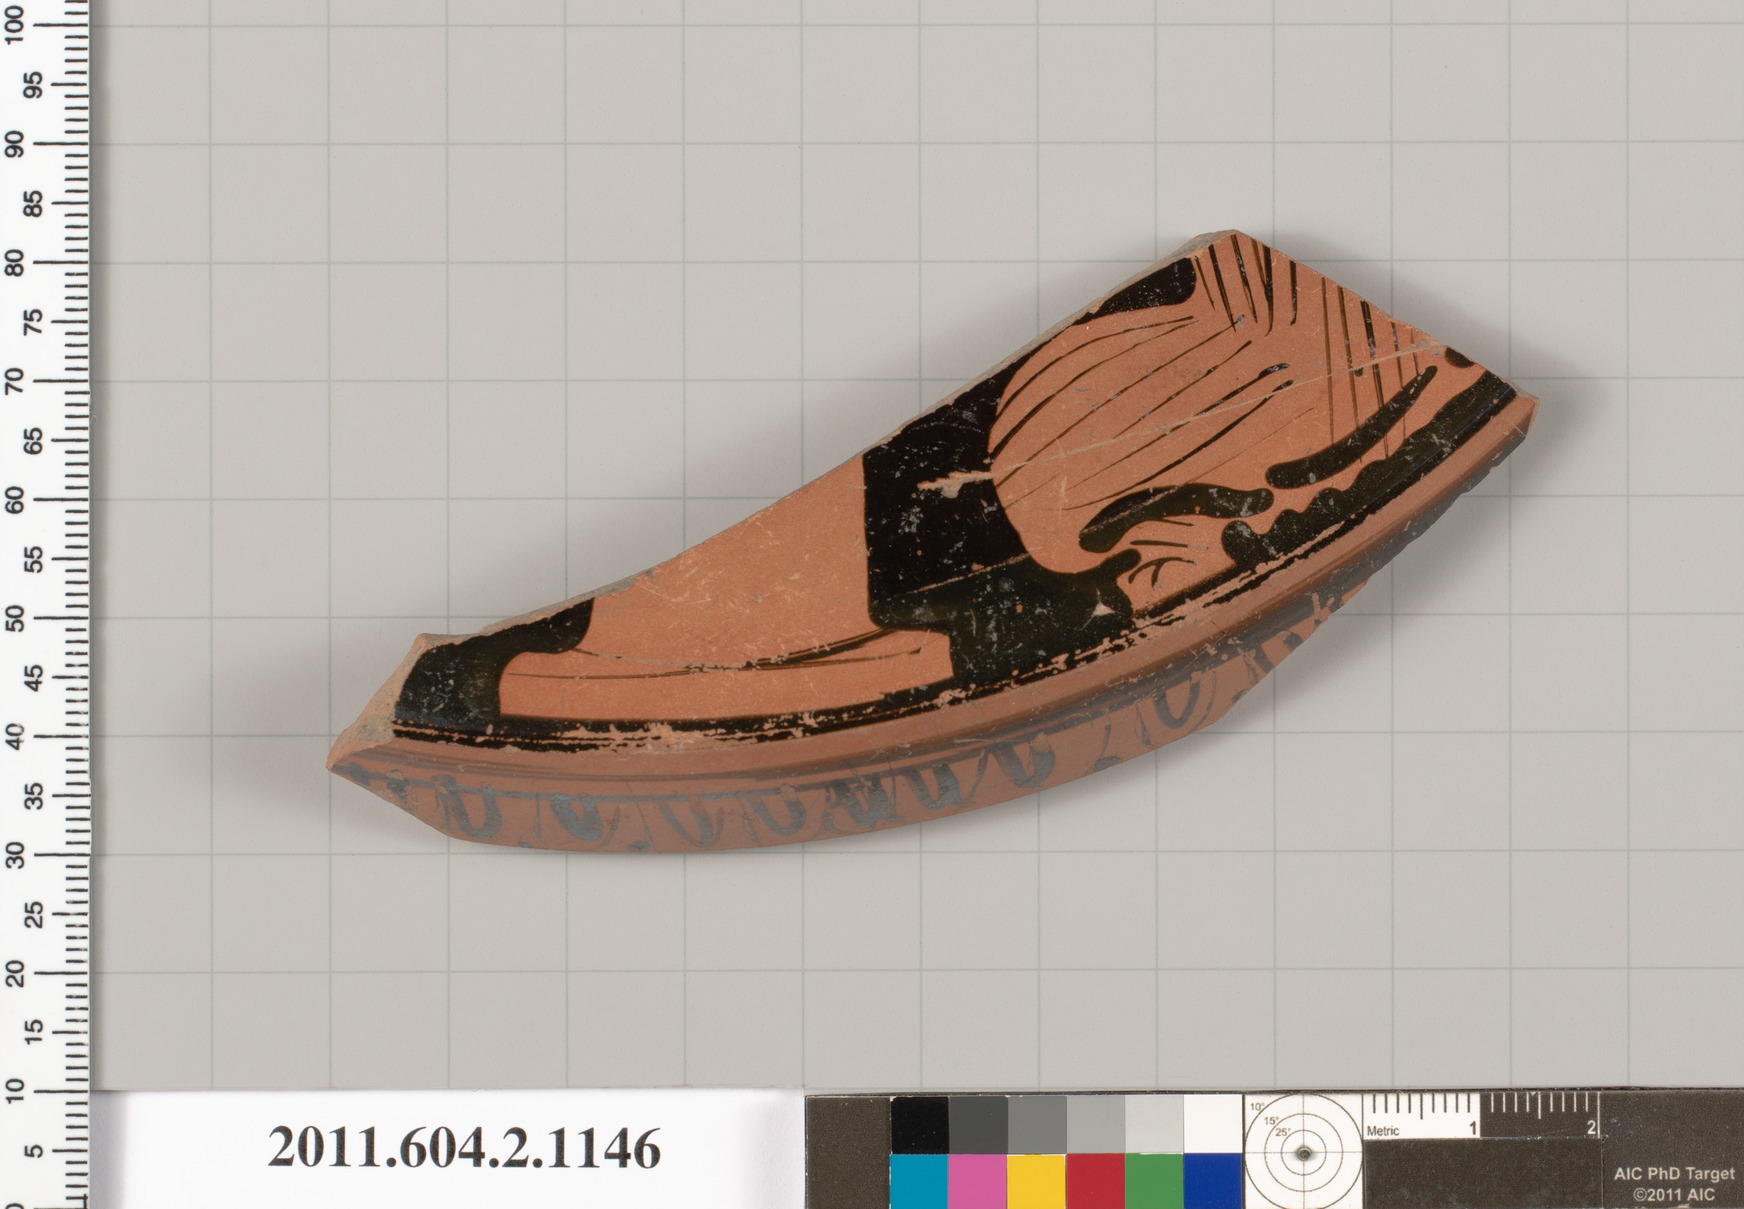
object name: lekanis fragment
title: Terracotta fragment of a lekanis lid (covered dish)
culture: greek, attic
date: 375-351 BCE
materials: terracotta